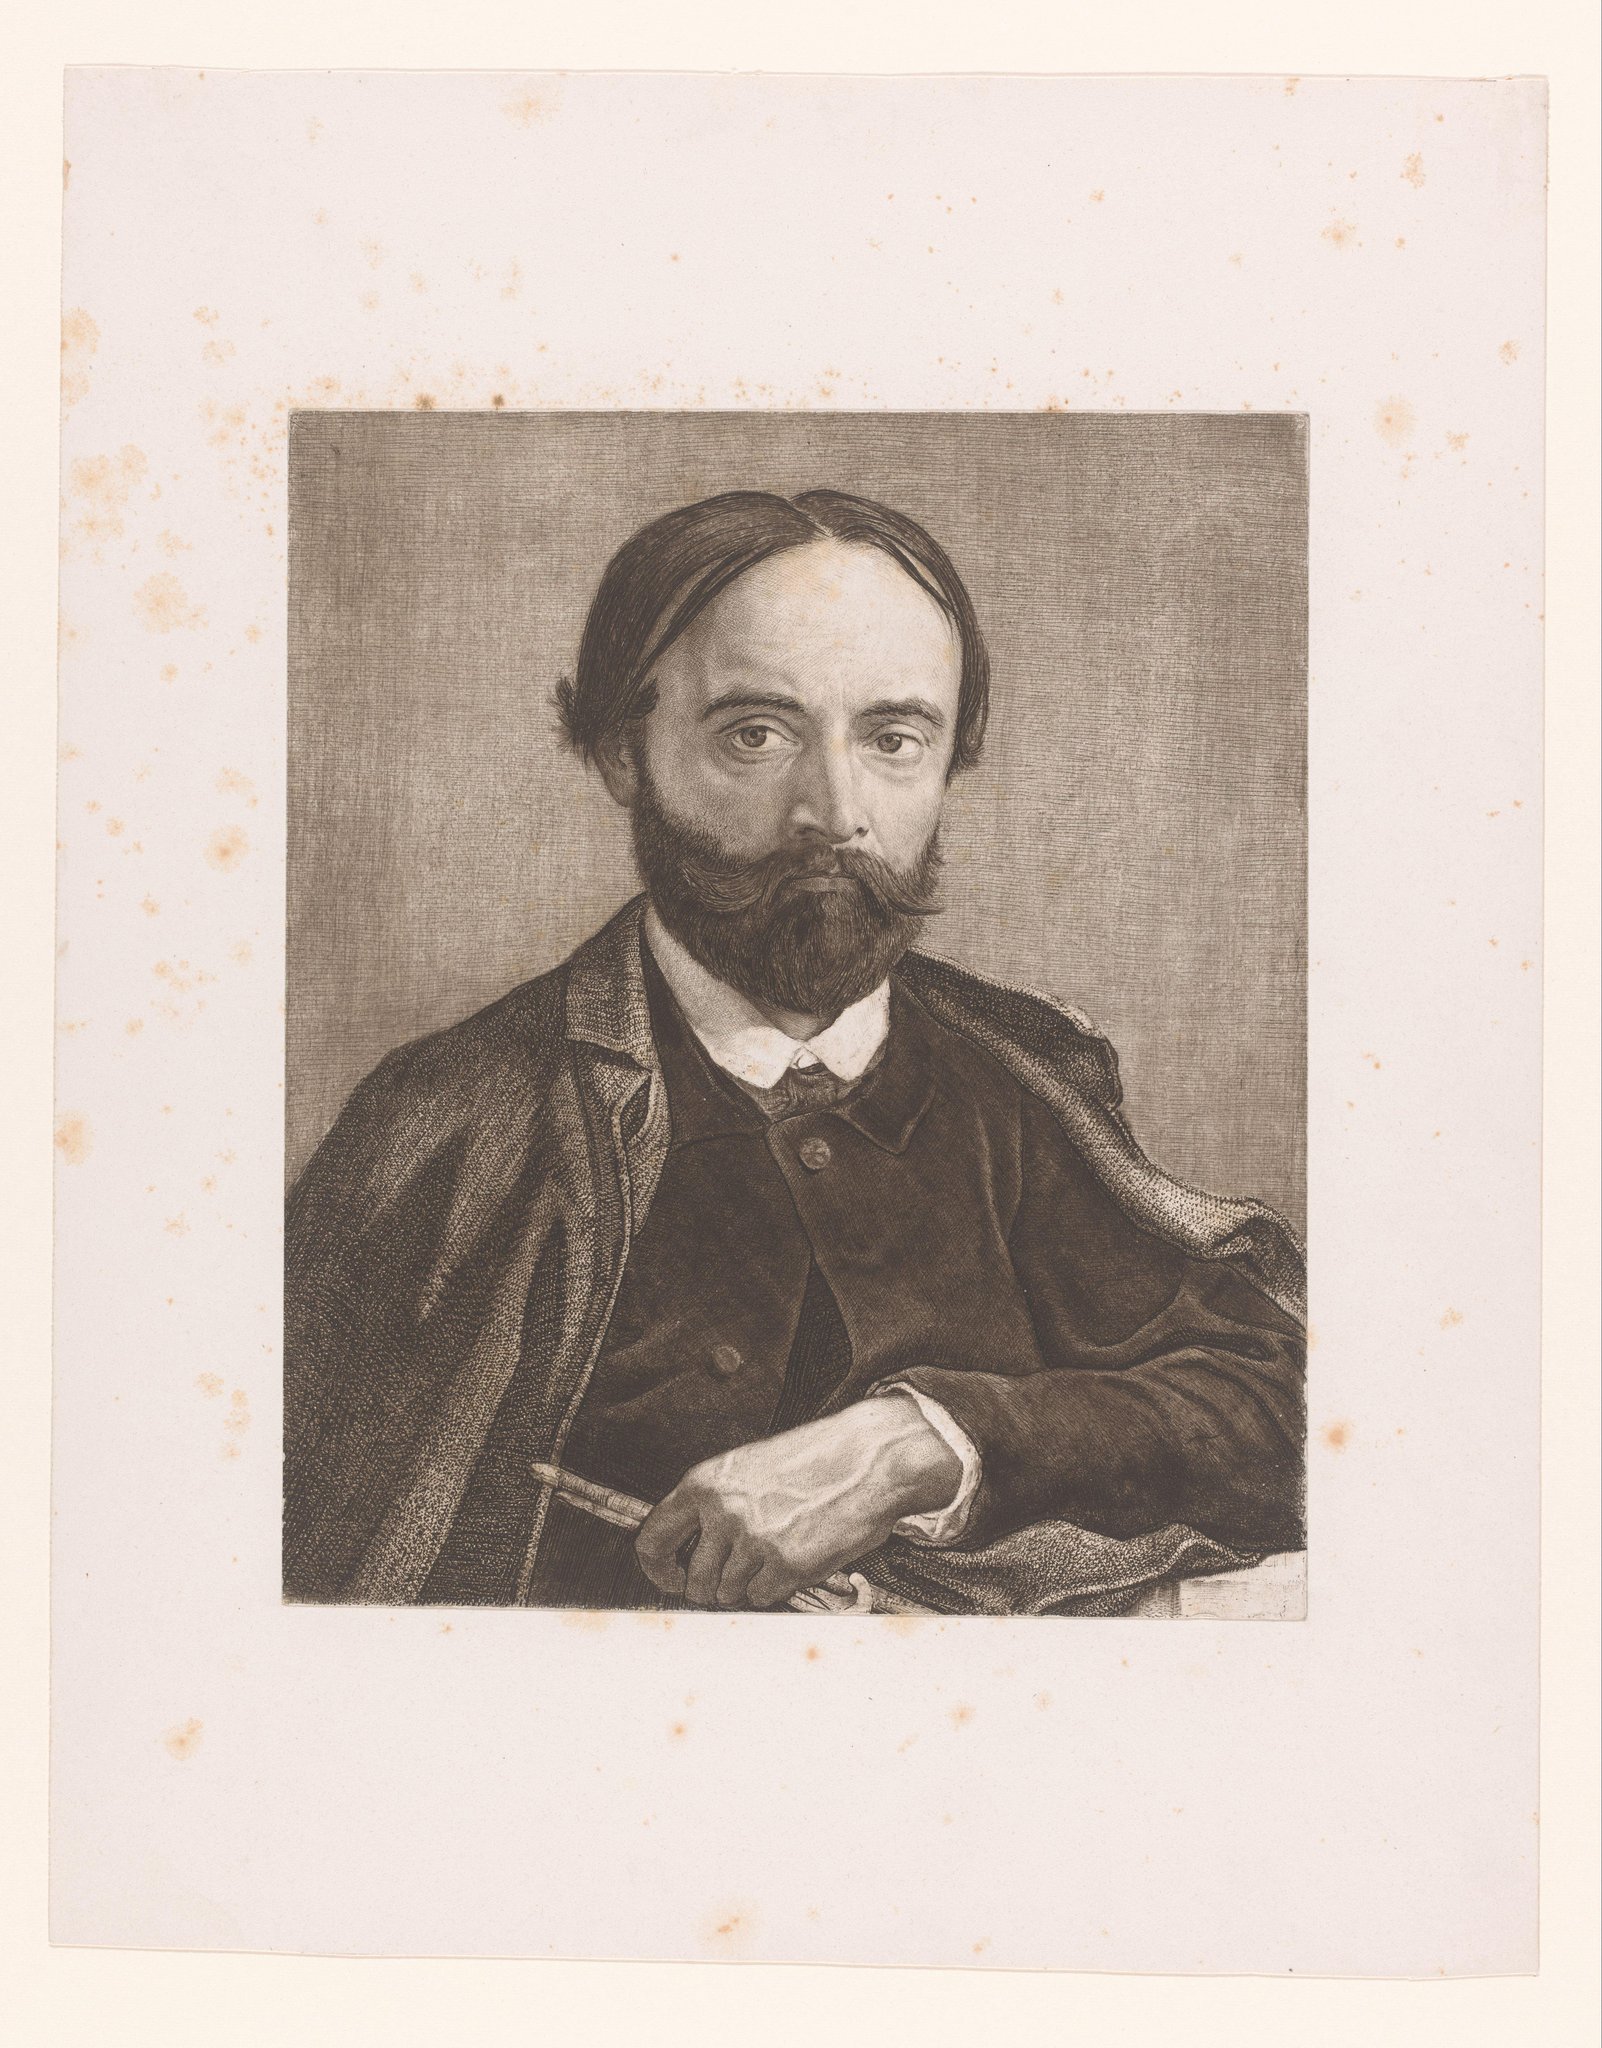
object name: print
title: Zelfportret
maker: charles verlat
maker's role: painter, print maker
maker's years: 1824-1890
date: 1868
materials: paper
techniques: drypoint, etching, intaglio, retroussage, roulette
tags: antwerp, painter, charles verlat, historical persons, portrait, self-portrait of artist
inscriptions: collector's mark: Lugt 2228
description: In 1868 maakte Verlat dit zelfportret. In 1882 bewerkte hij de plaat en gaf het gezicht oudere trekken. Dit deed hij in verschillende stappen waarvan de diverse staten ook in de coll. Rijksmuseum Amsterdam zijn. Het resultaat was een zelfportret dat meer paste bij hoe hij er op dat latere moment in zijn leven uitzag.